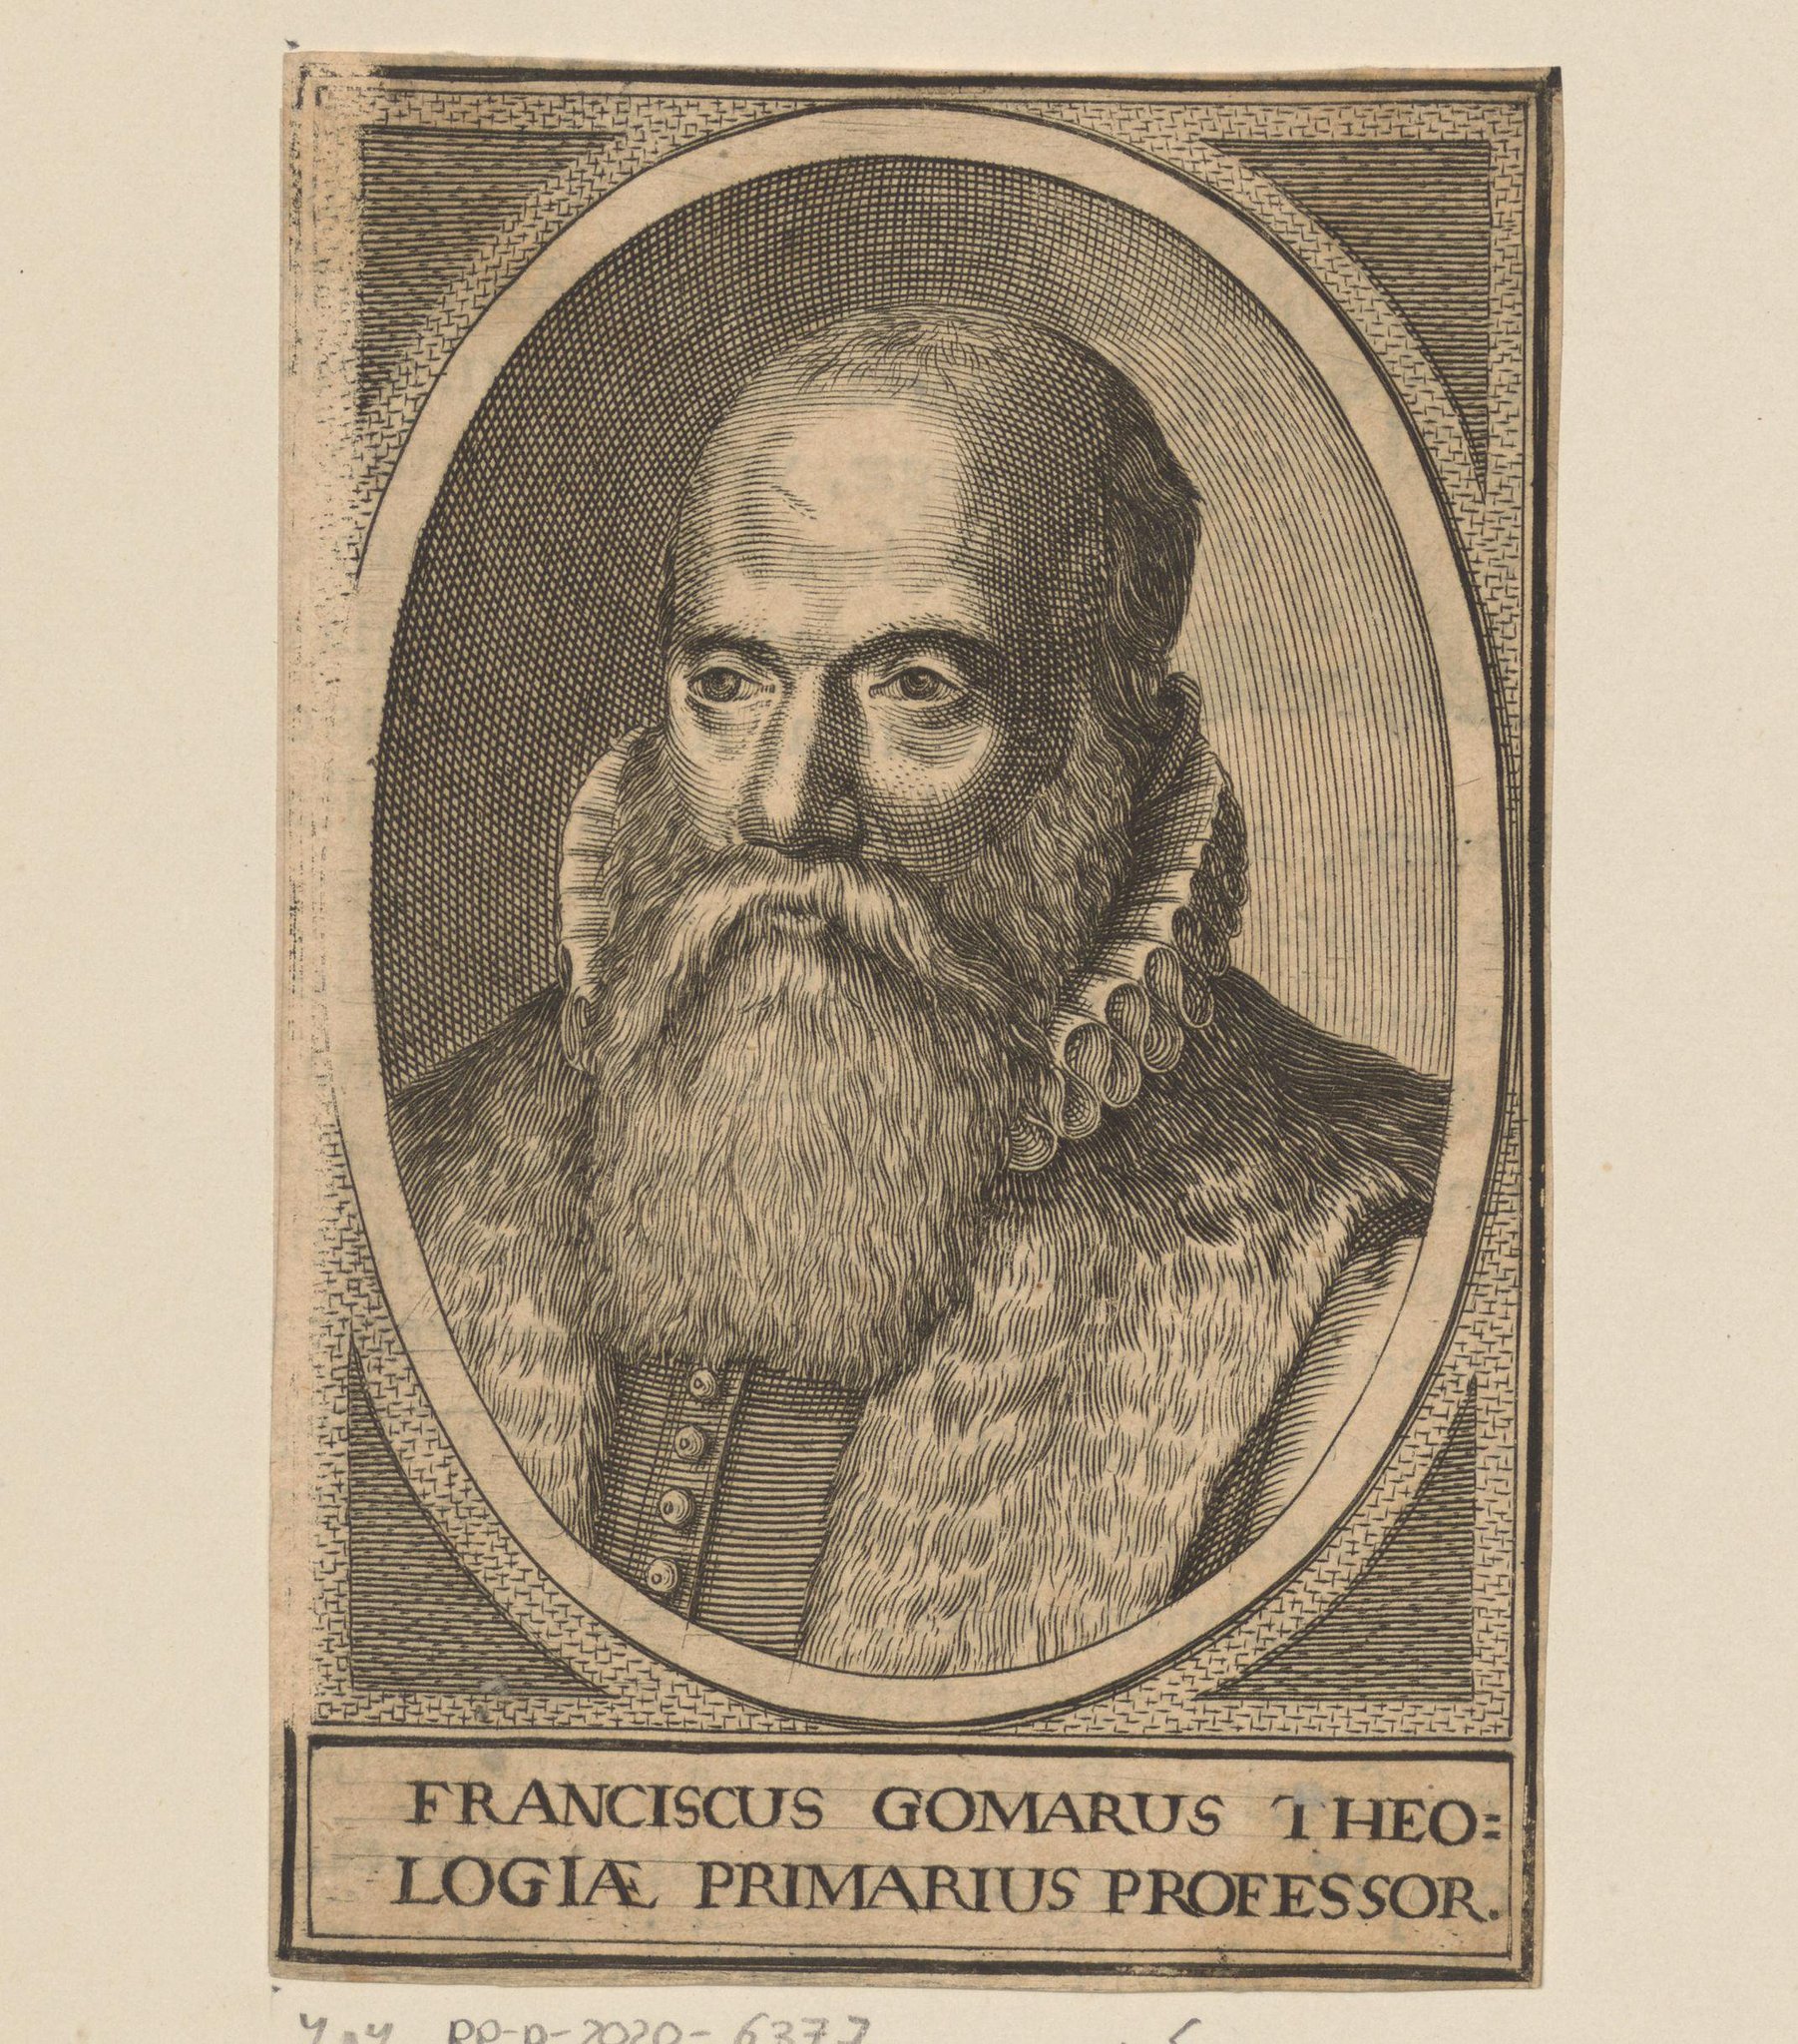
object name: print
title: Portret van Franciscus Gomarus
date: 1614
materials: paper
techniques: engraving, letterpress printing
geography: katwijk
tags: bruges, theologian, historical persons, professor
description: Prent uit: Meurs, Johannes. Illustrium Hollandiae et Westfrisiae ordinum alma Academia Leidensis. Katwijk: Jacob Marcus en Joost van Colster, 1614, p. 41 [vermoedelijk gedrukt en/of uitgegeven in Leiden].